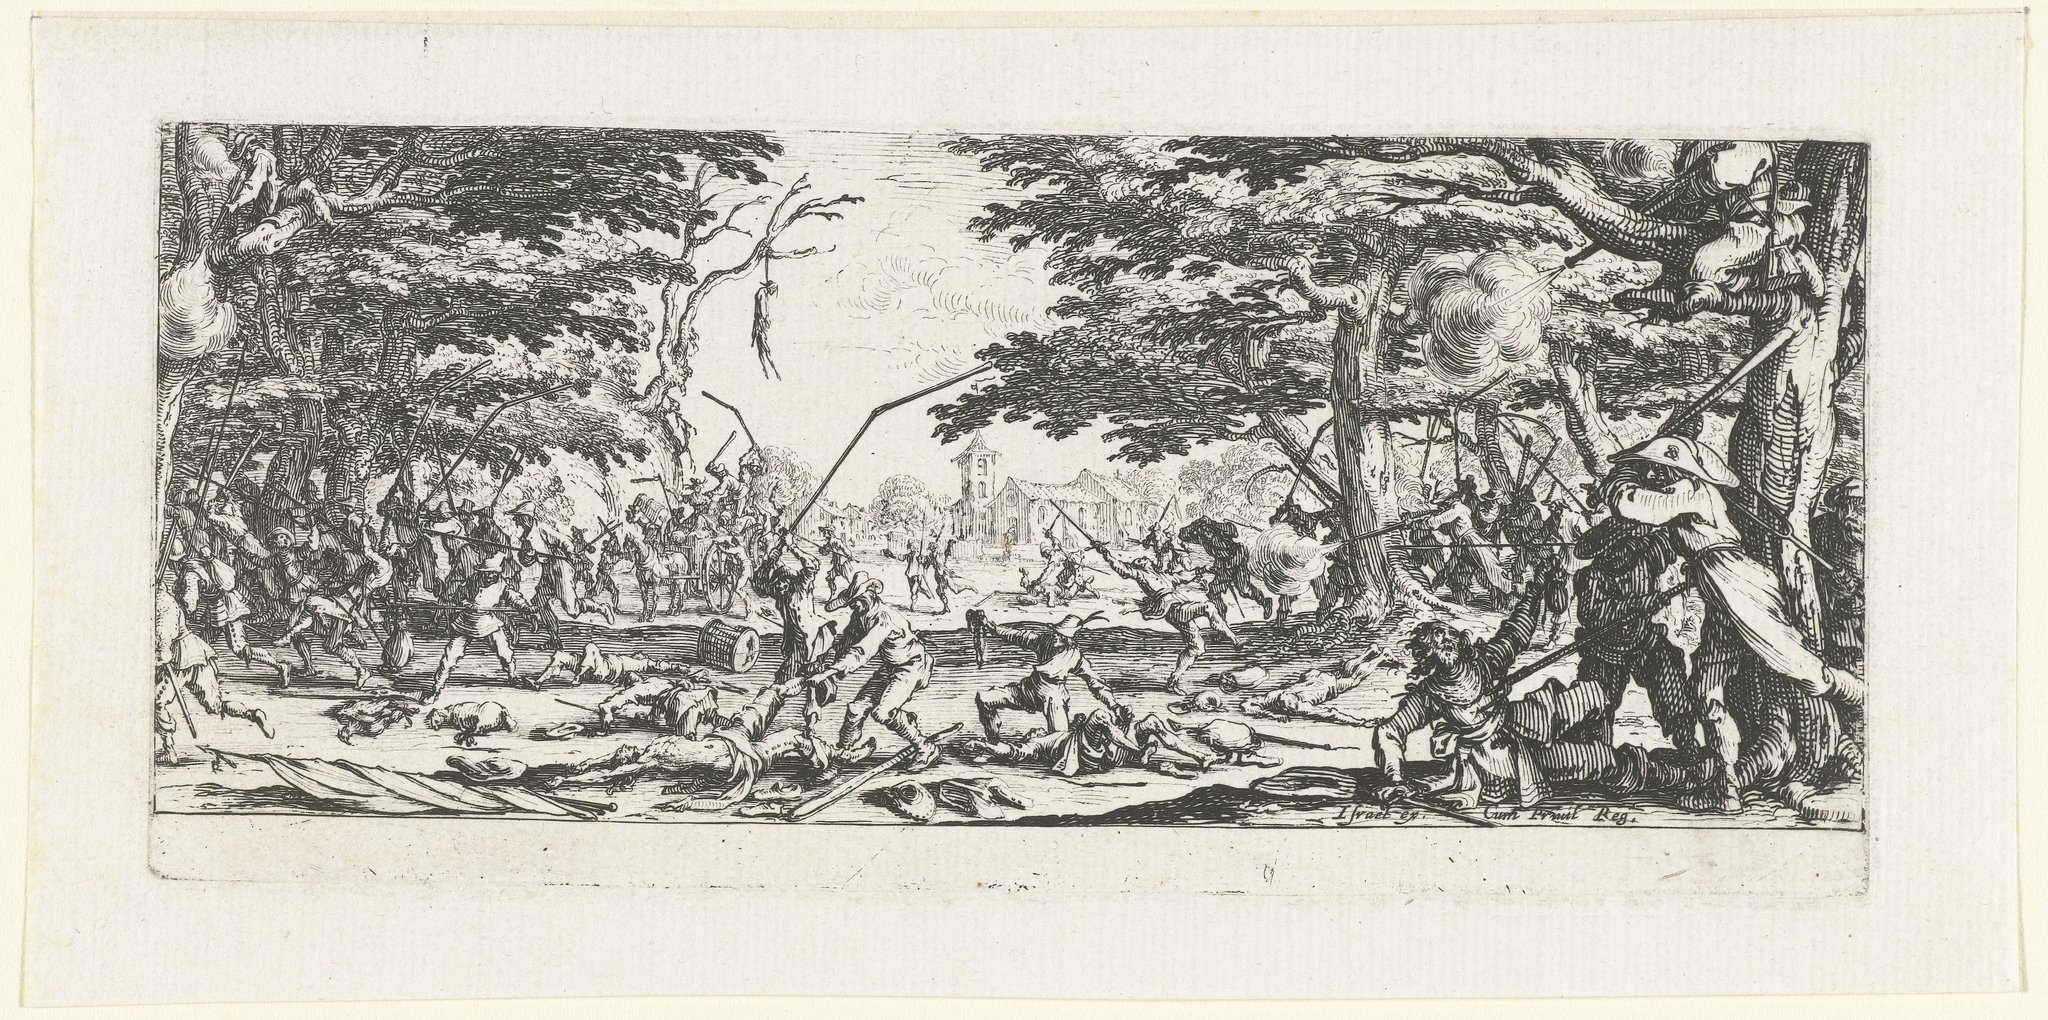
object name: print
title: De gruwelen van de oorlog (groot)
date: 1633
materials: paper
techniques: etching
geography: paris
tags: fight between farmers and soldiers, village, soldiers and civilians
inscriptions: collector's mark: Lugt 240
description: Aan de rand van een dorp nemen boeren met zeisen en knuppels soldaten te grazen. Onder de voorstelling een lege marge. Deze prent is onderdeel van een serie van 17 (18 incl. titelprent) prenten met voorstellingen van diverse soorten ellende die oorlogvoering met zich meebrengt.